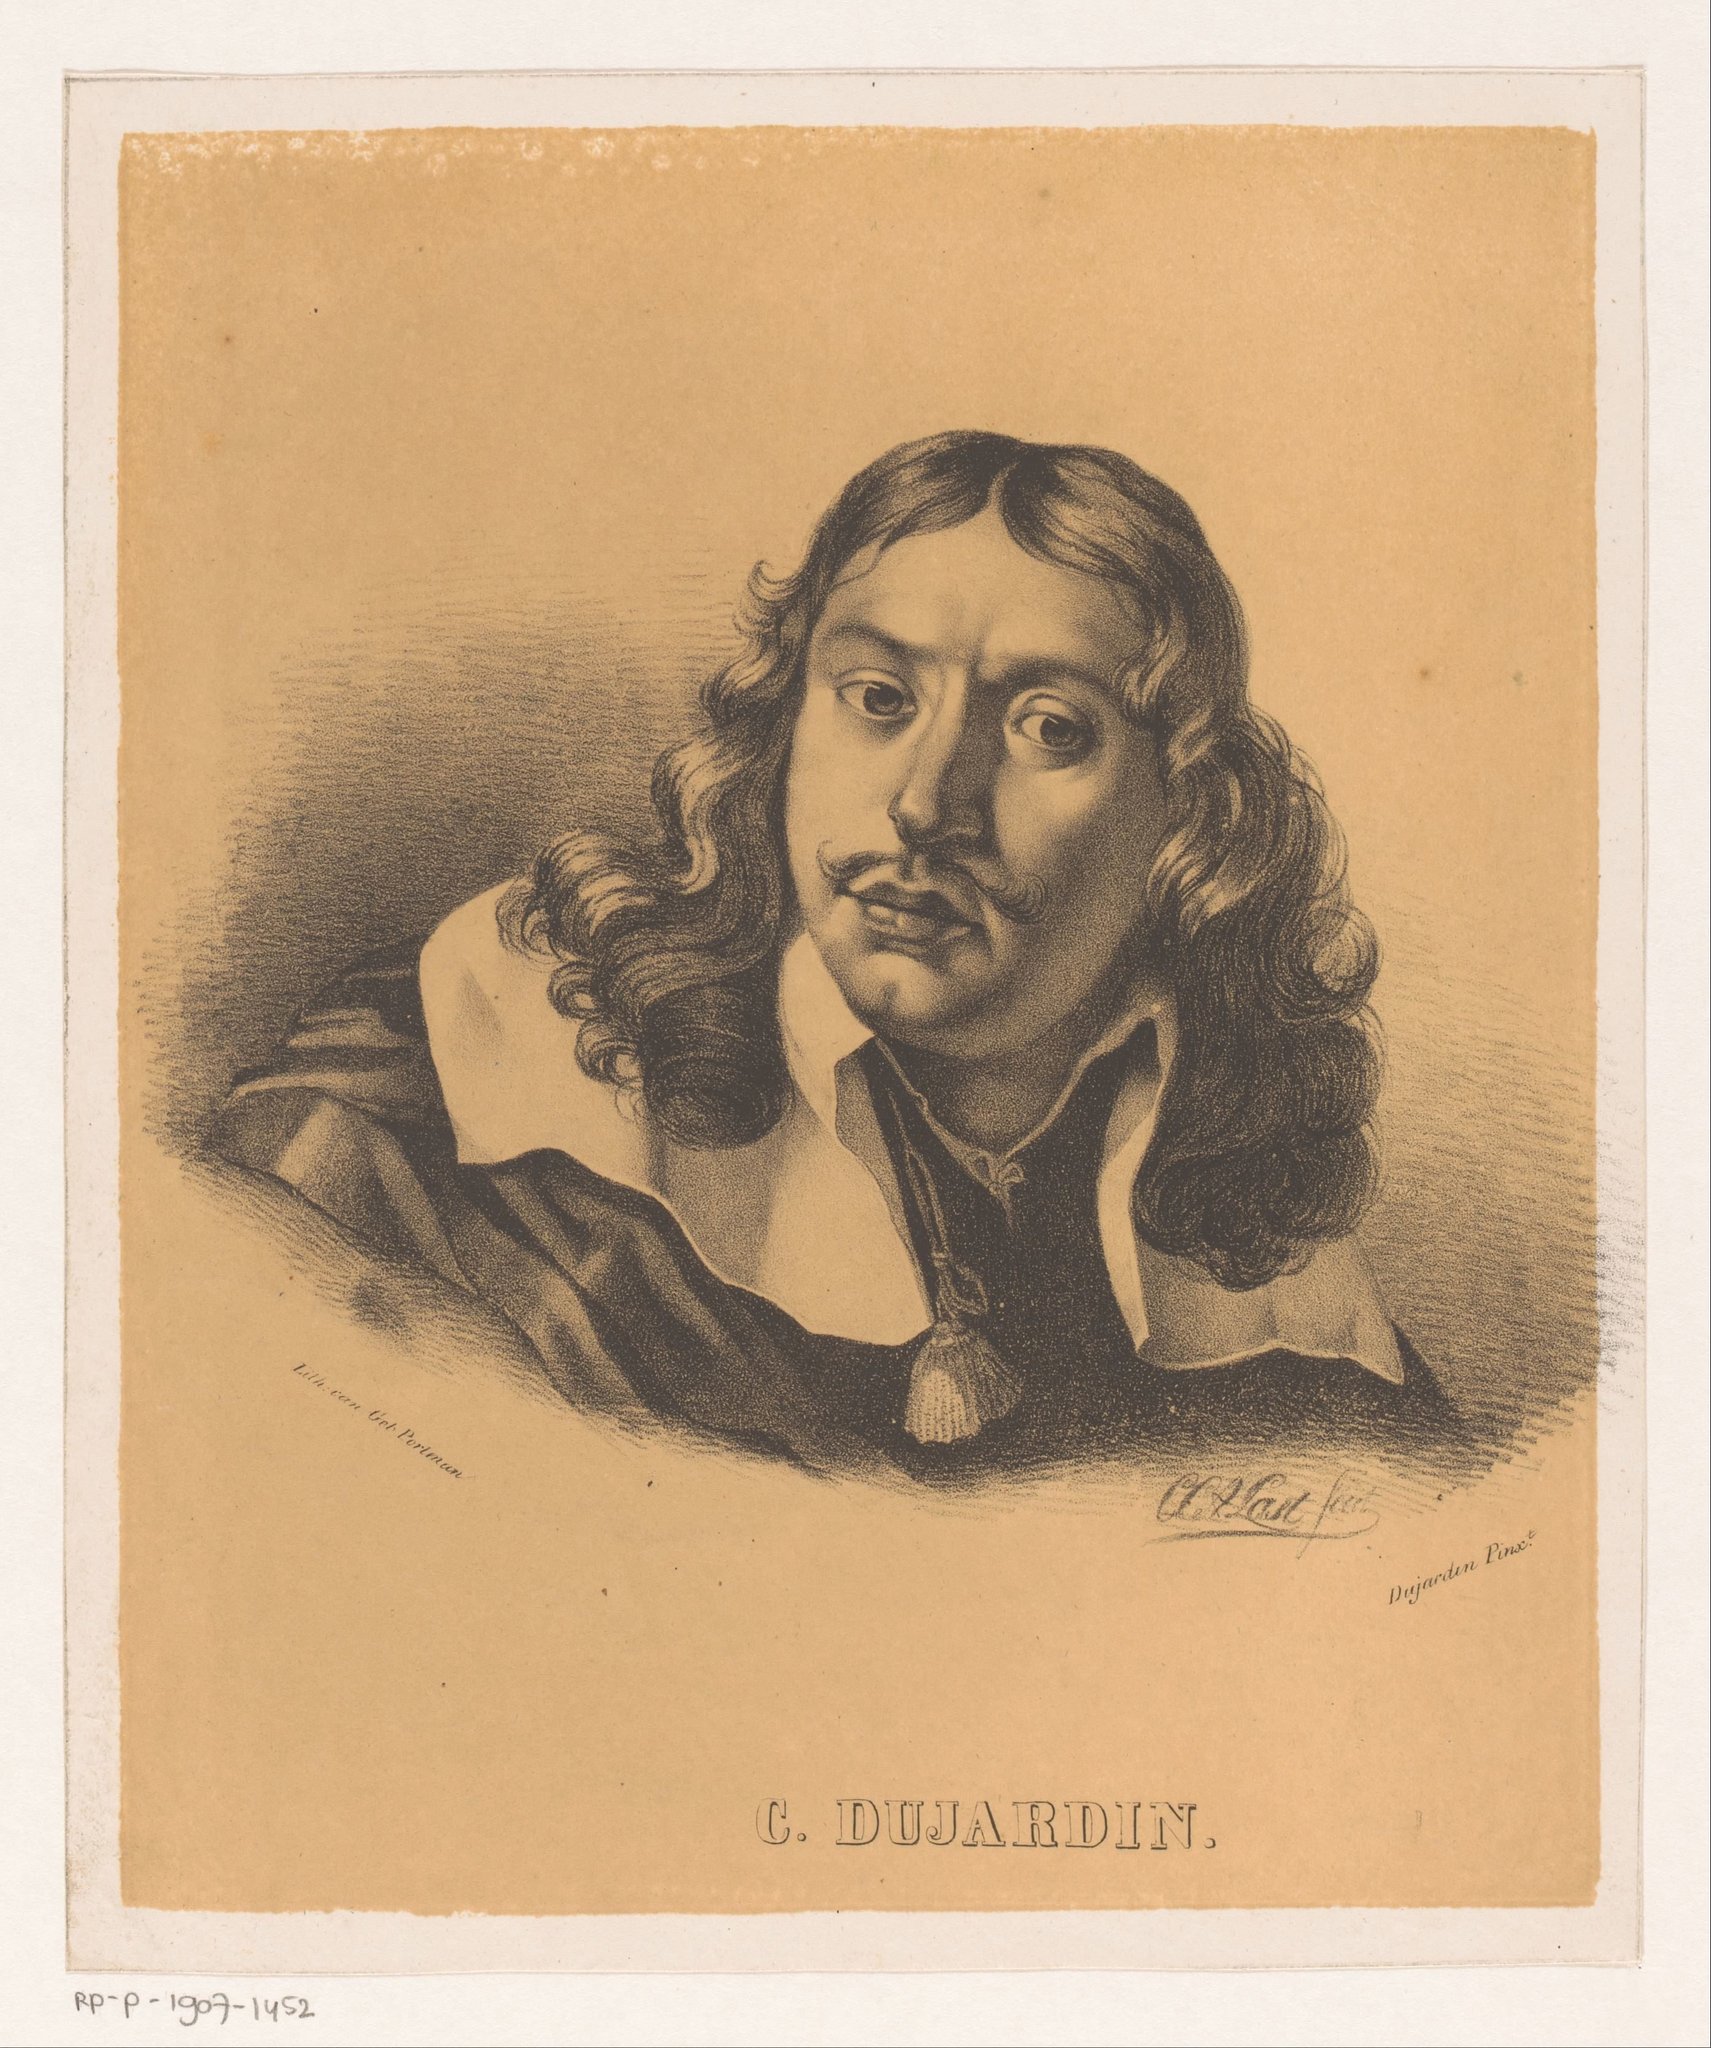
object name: print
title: Portret van Karel Dujardin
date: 1827-1828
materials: paper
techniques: tone lithography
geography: netherlands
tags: amsterdam, venice, painter, print maker, draughtsman, karel du jardin, portrait, self-portrait of artist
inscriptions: collector's mark: Lugt 2228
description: Naar een zelfportret door Karel Dujardin uit 1662. Onder het portret zijn naam.